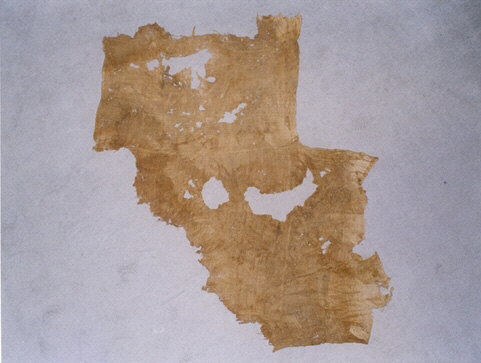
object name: pant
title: Linen pants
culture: alanic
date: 601-900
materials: linen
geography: caucasus